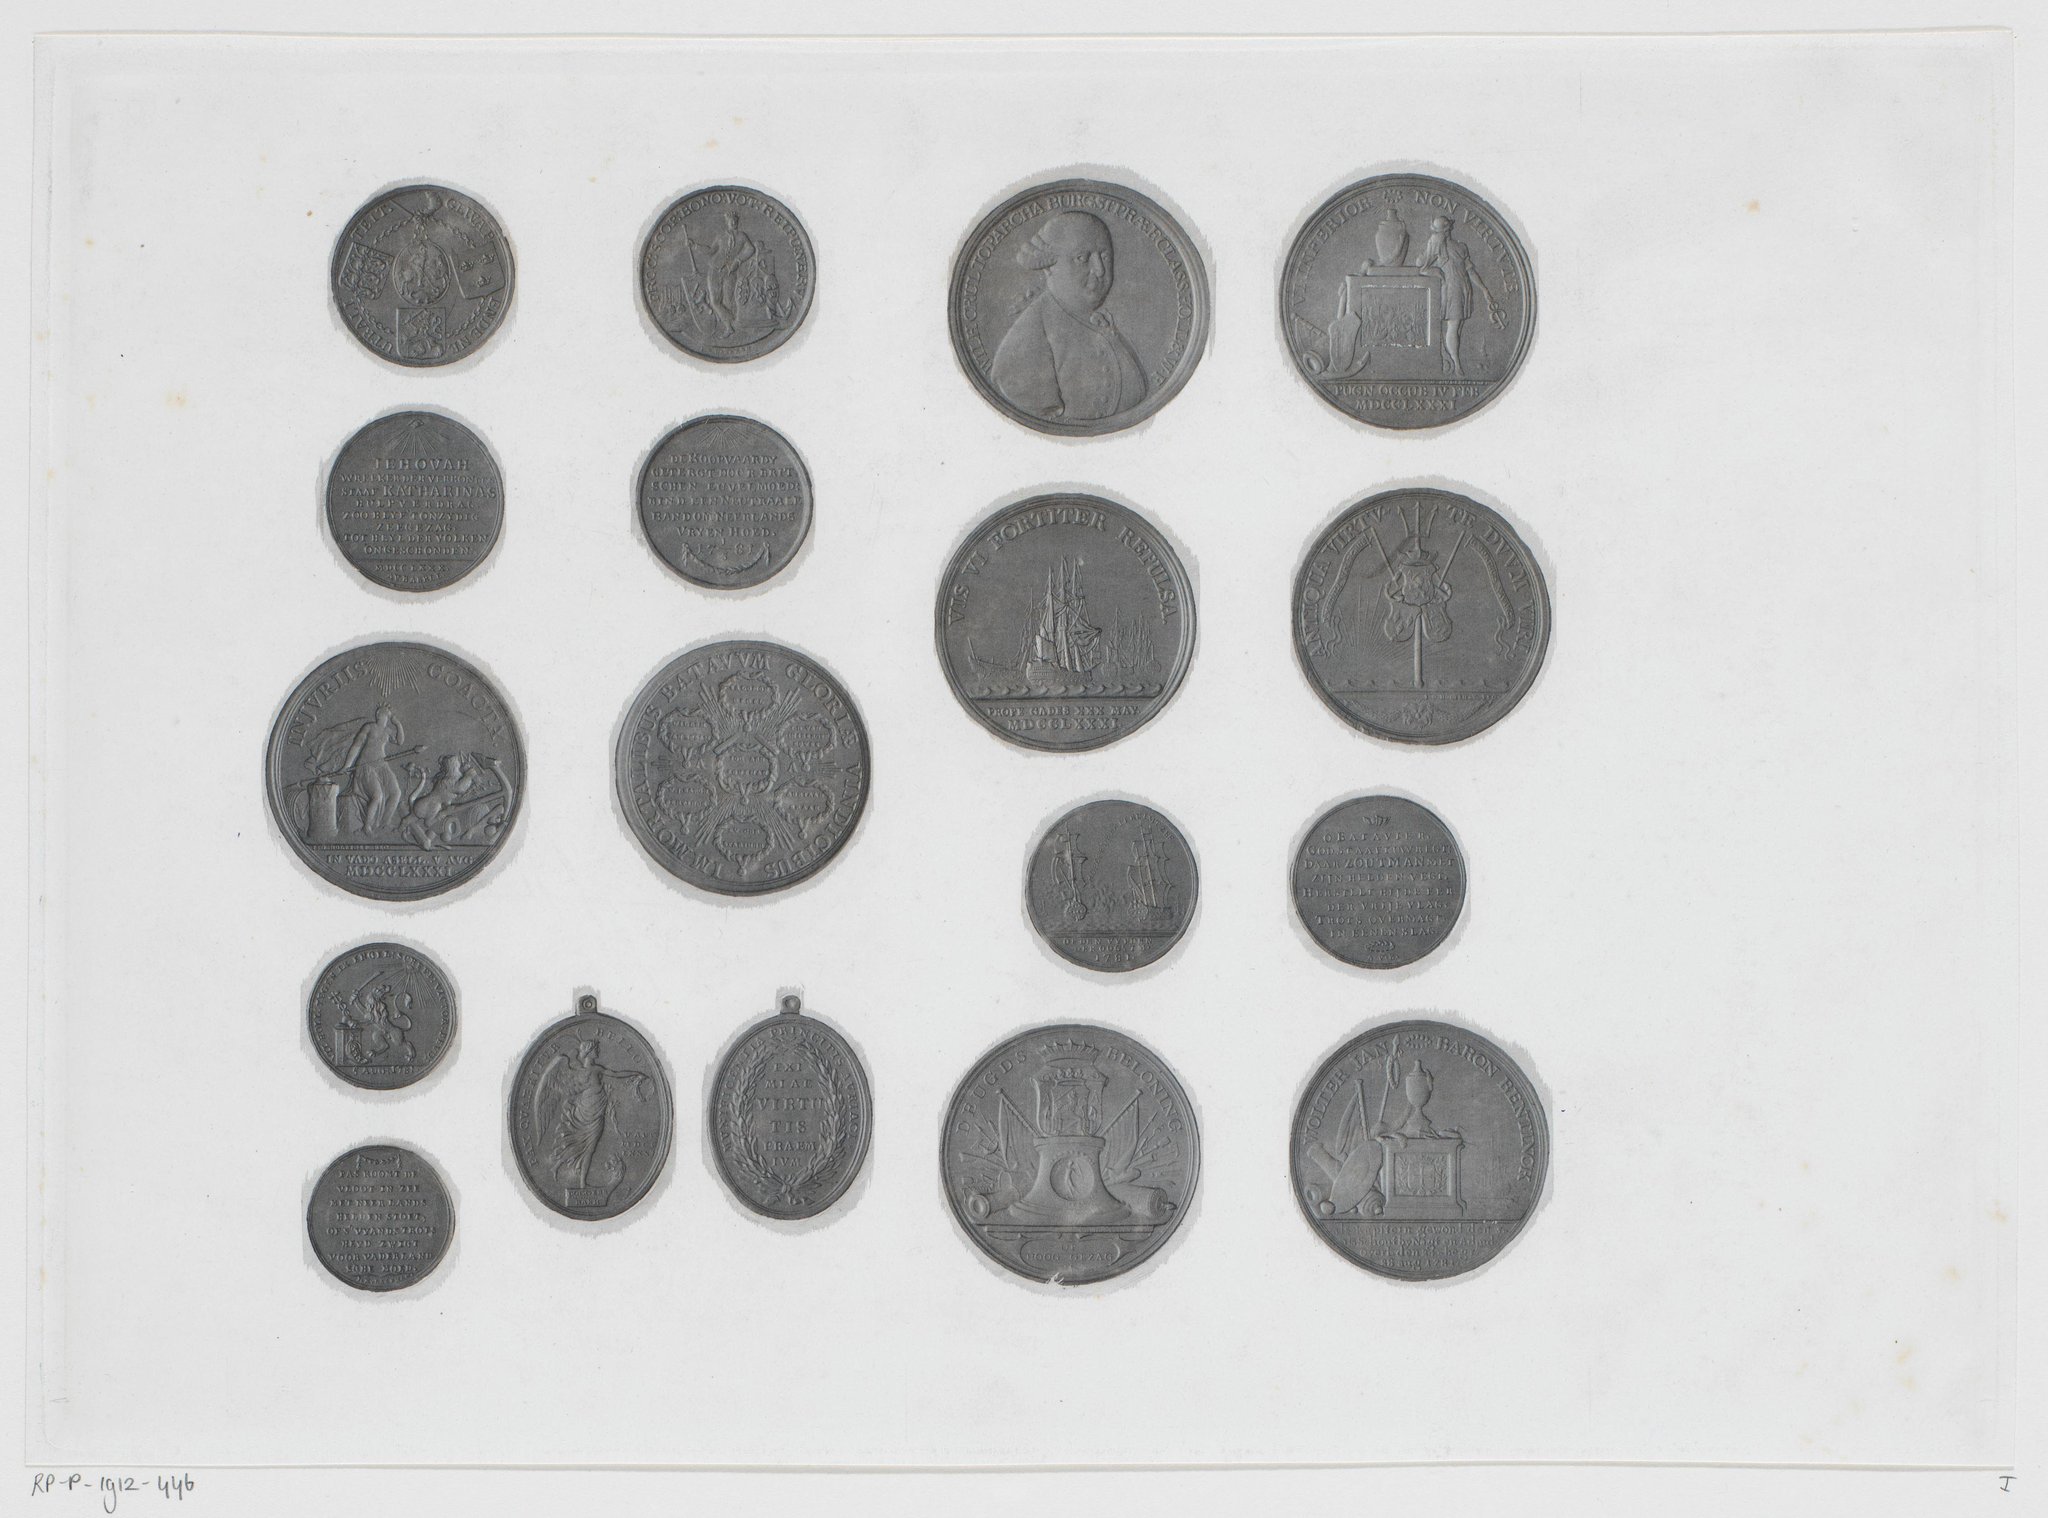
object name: print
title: Verschillende munten en gedenkpenningen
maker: jan dam steuerwald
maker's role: print maker, printer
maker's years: 1805-1869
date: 1839-1863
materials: paper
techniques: relief engraving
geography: netherlands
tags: coin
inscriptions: collector's mark: Lugt 2228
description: Van iedere munt zijn de voor- en achterzijde weergegeven.